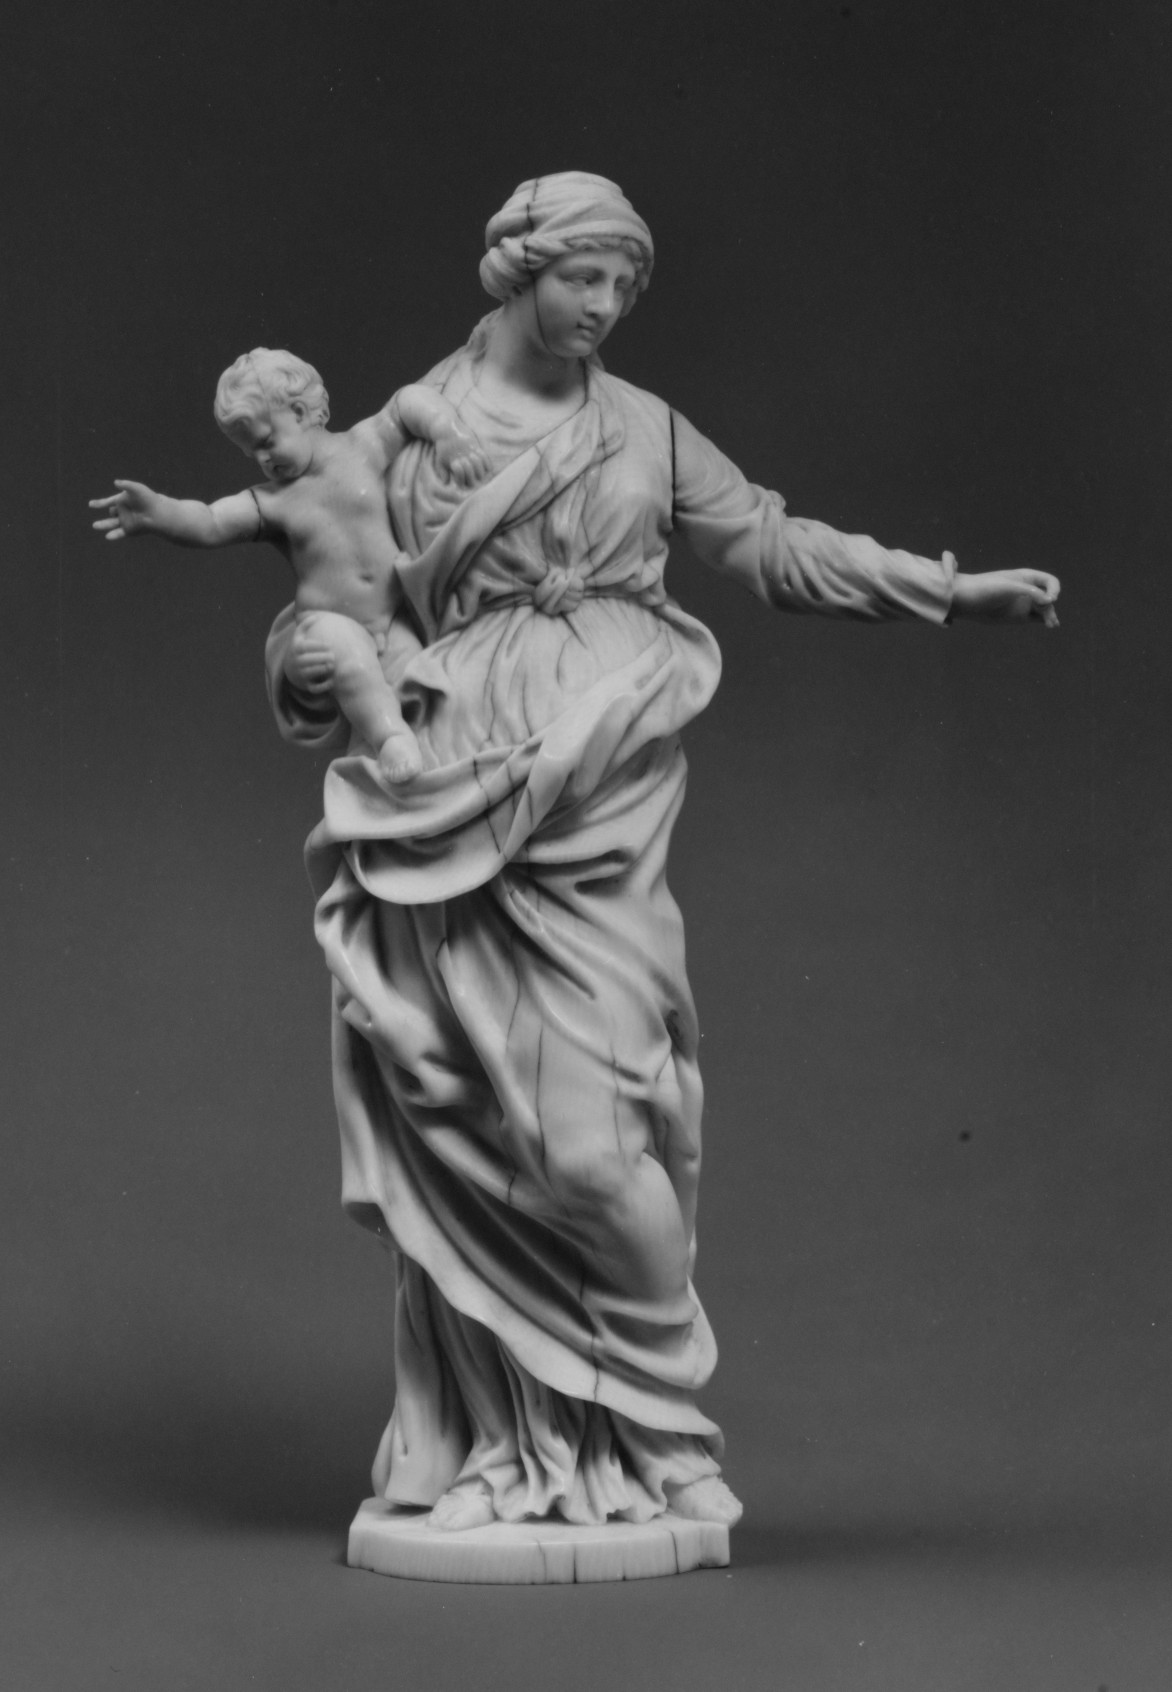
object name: statuette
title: Madonna and Child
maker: alessandro algardi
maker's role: artist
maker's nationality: italian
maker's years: 1598-1654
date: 1634-1666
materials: ivory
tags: madonna and child